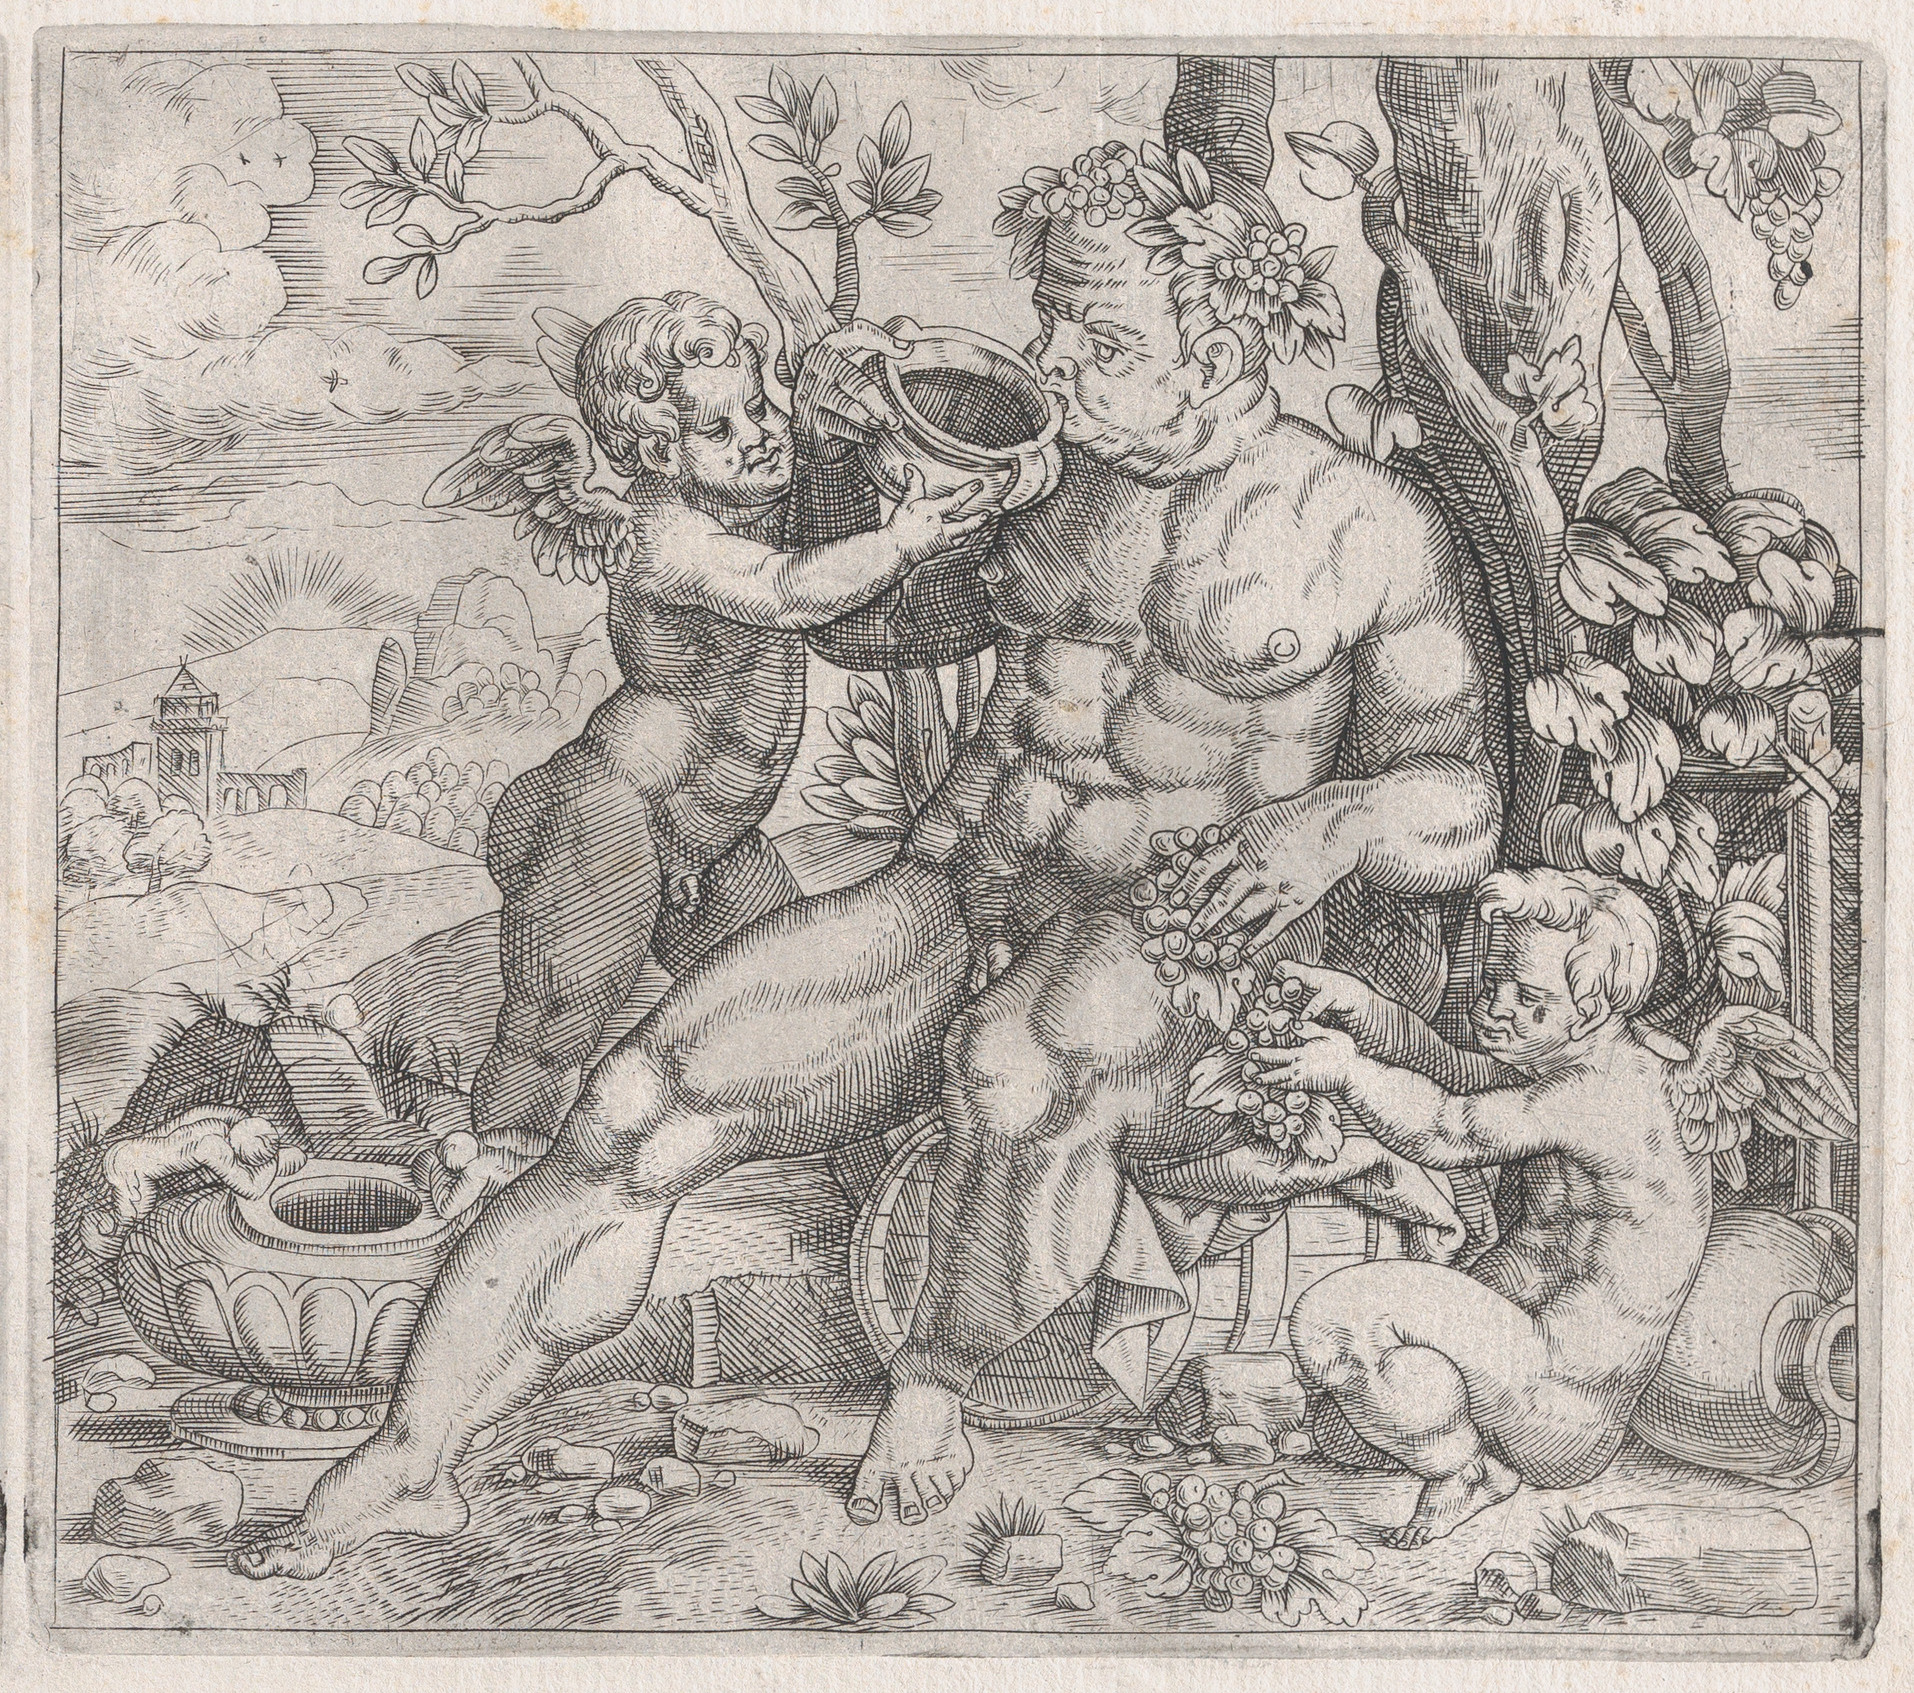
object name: print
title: Bacchus, Seated, Drinking from a Vase Presented by a Putto, from "Speculum Romanae Magnificentiae"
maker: Anonymous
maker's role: artist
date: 1501-1600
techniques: etching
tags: putti,bacchus,drinking